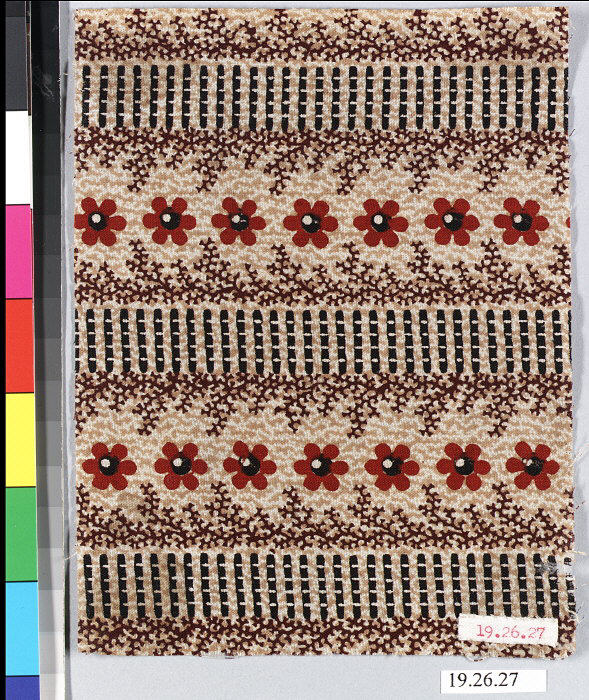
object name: sample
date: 1840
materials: cotton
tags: flowers